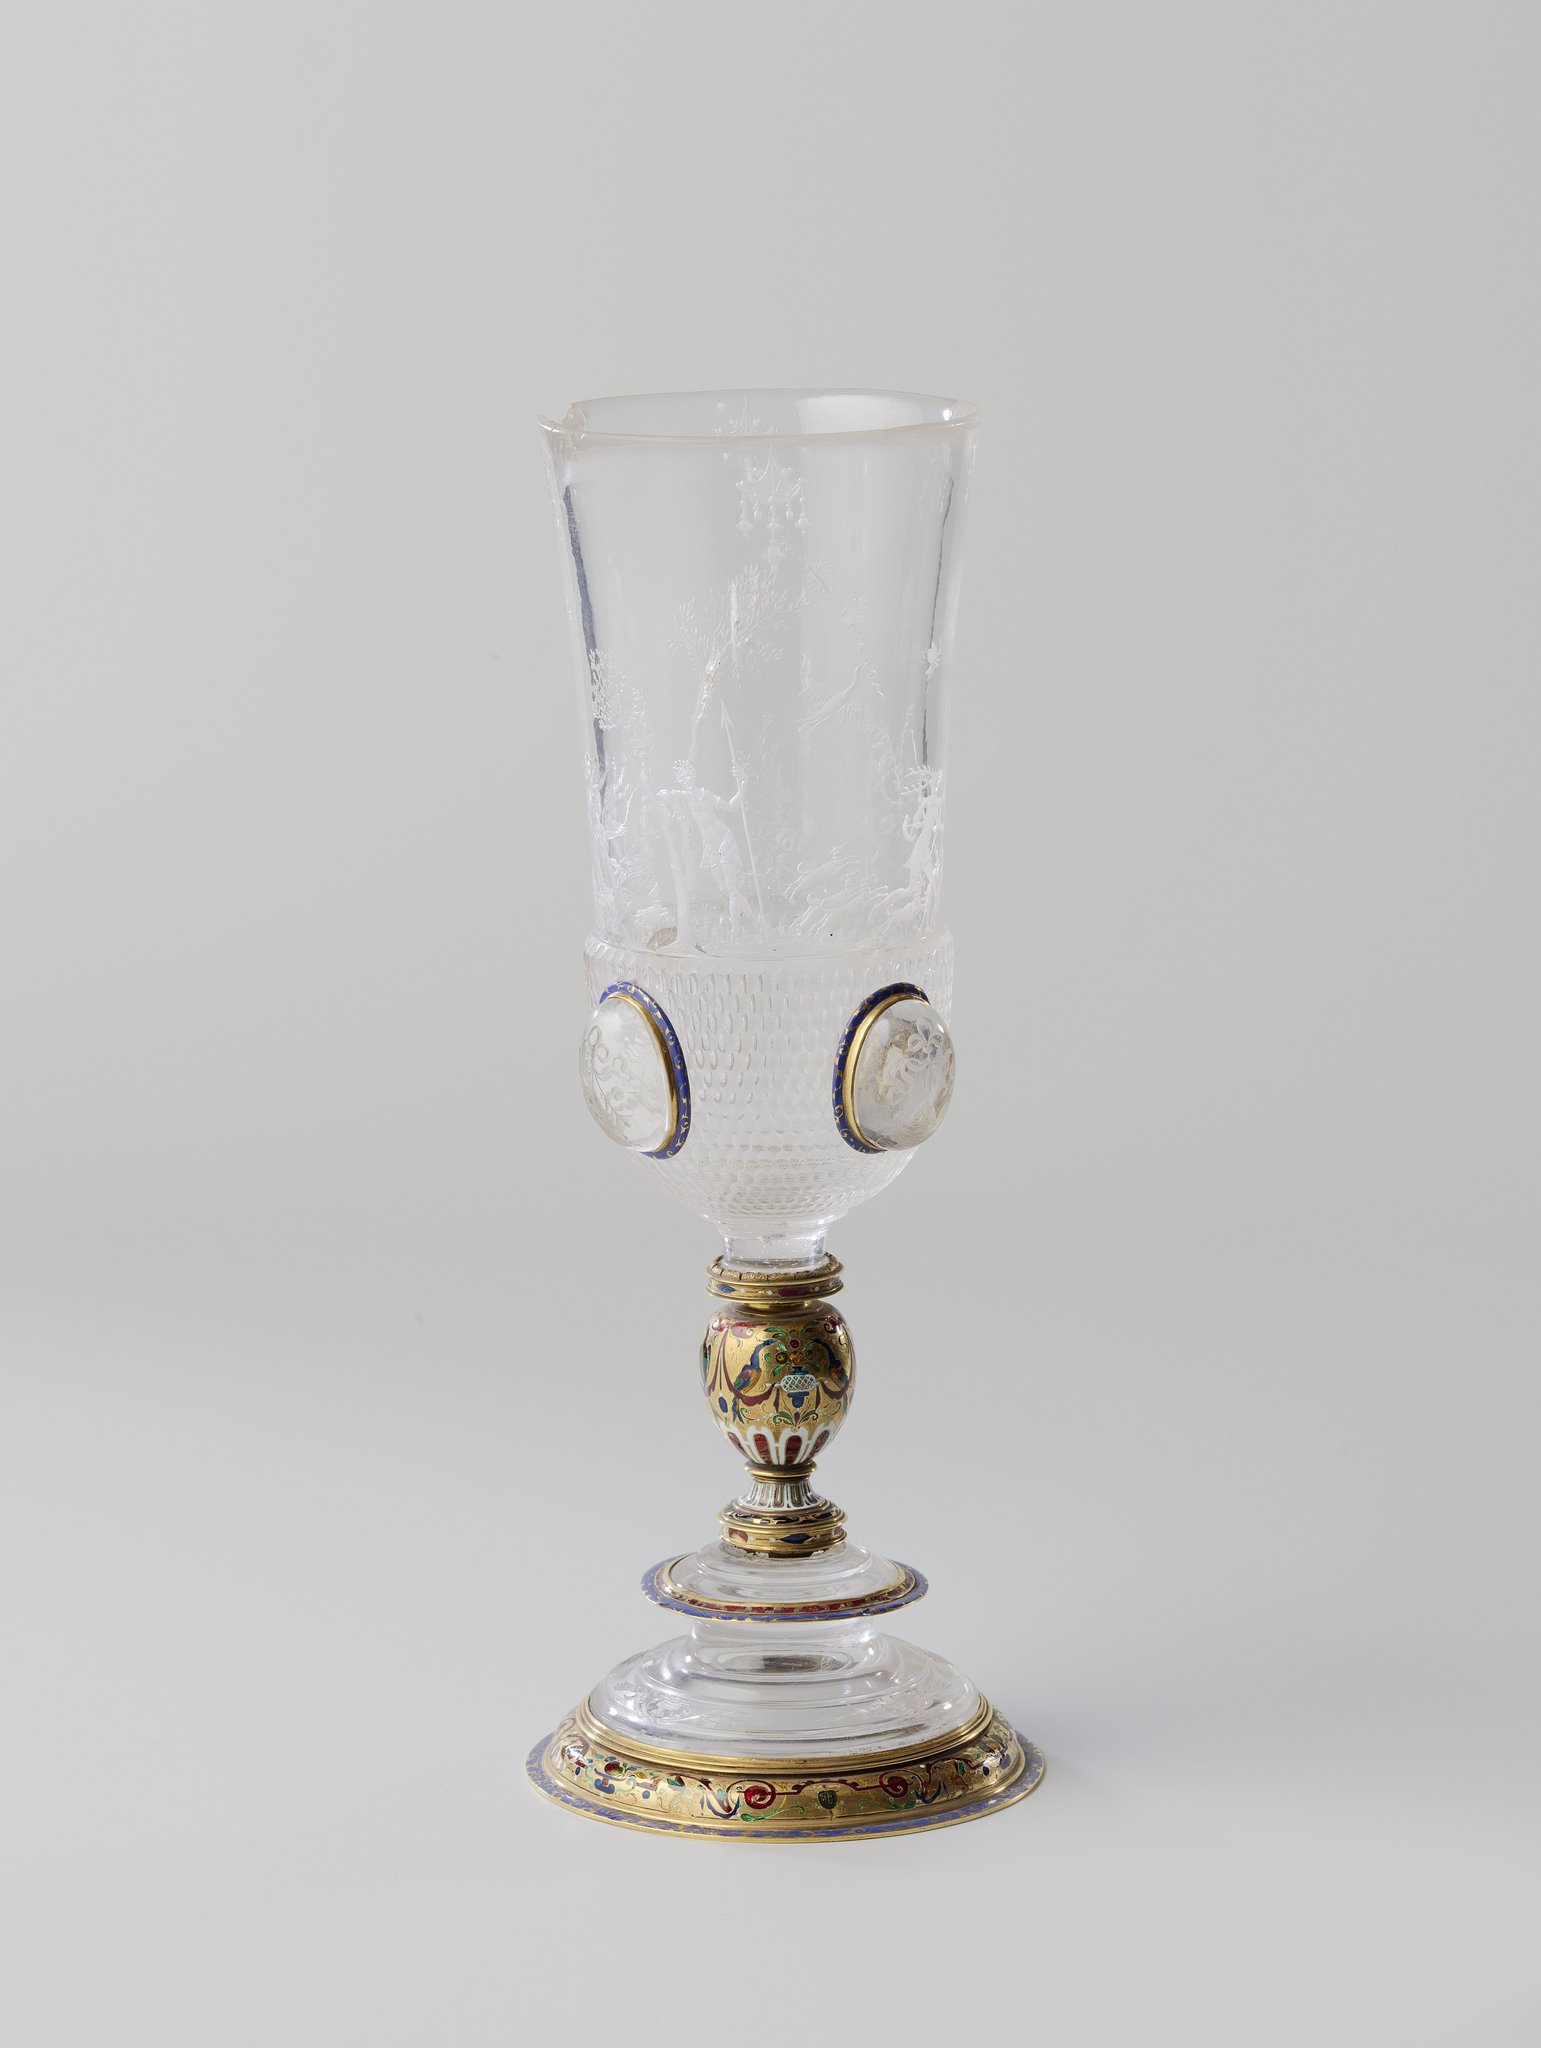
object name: goblet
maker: Anonymous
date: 1600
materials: stone, gold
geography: bohemia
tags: (story of) diana (artemis)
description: Bokaal van bergkristal en een montuur van goud met email. Rondom versierd in mat slijpwerk met een voorstelling van Diana en Actaeon.